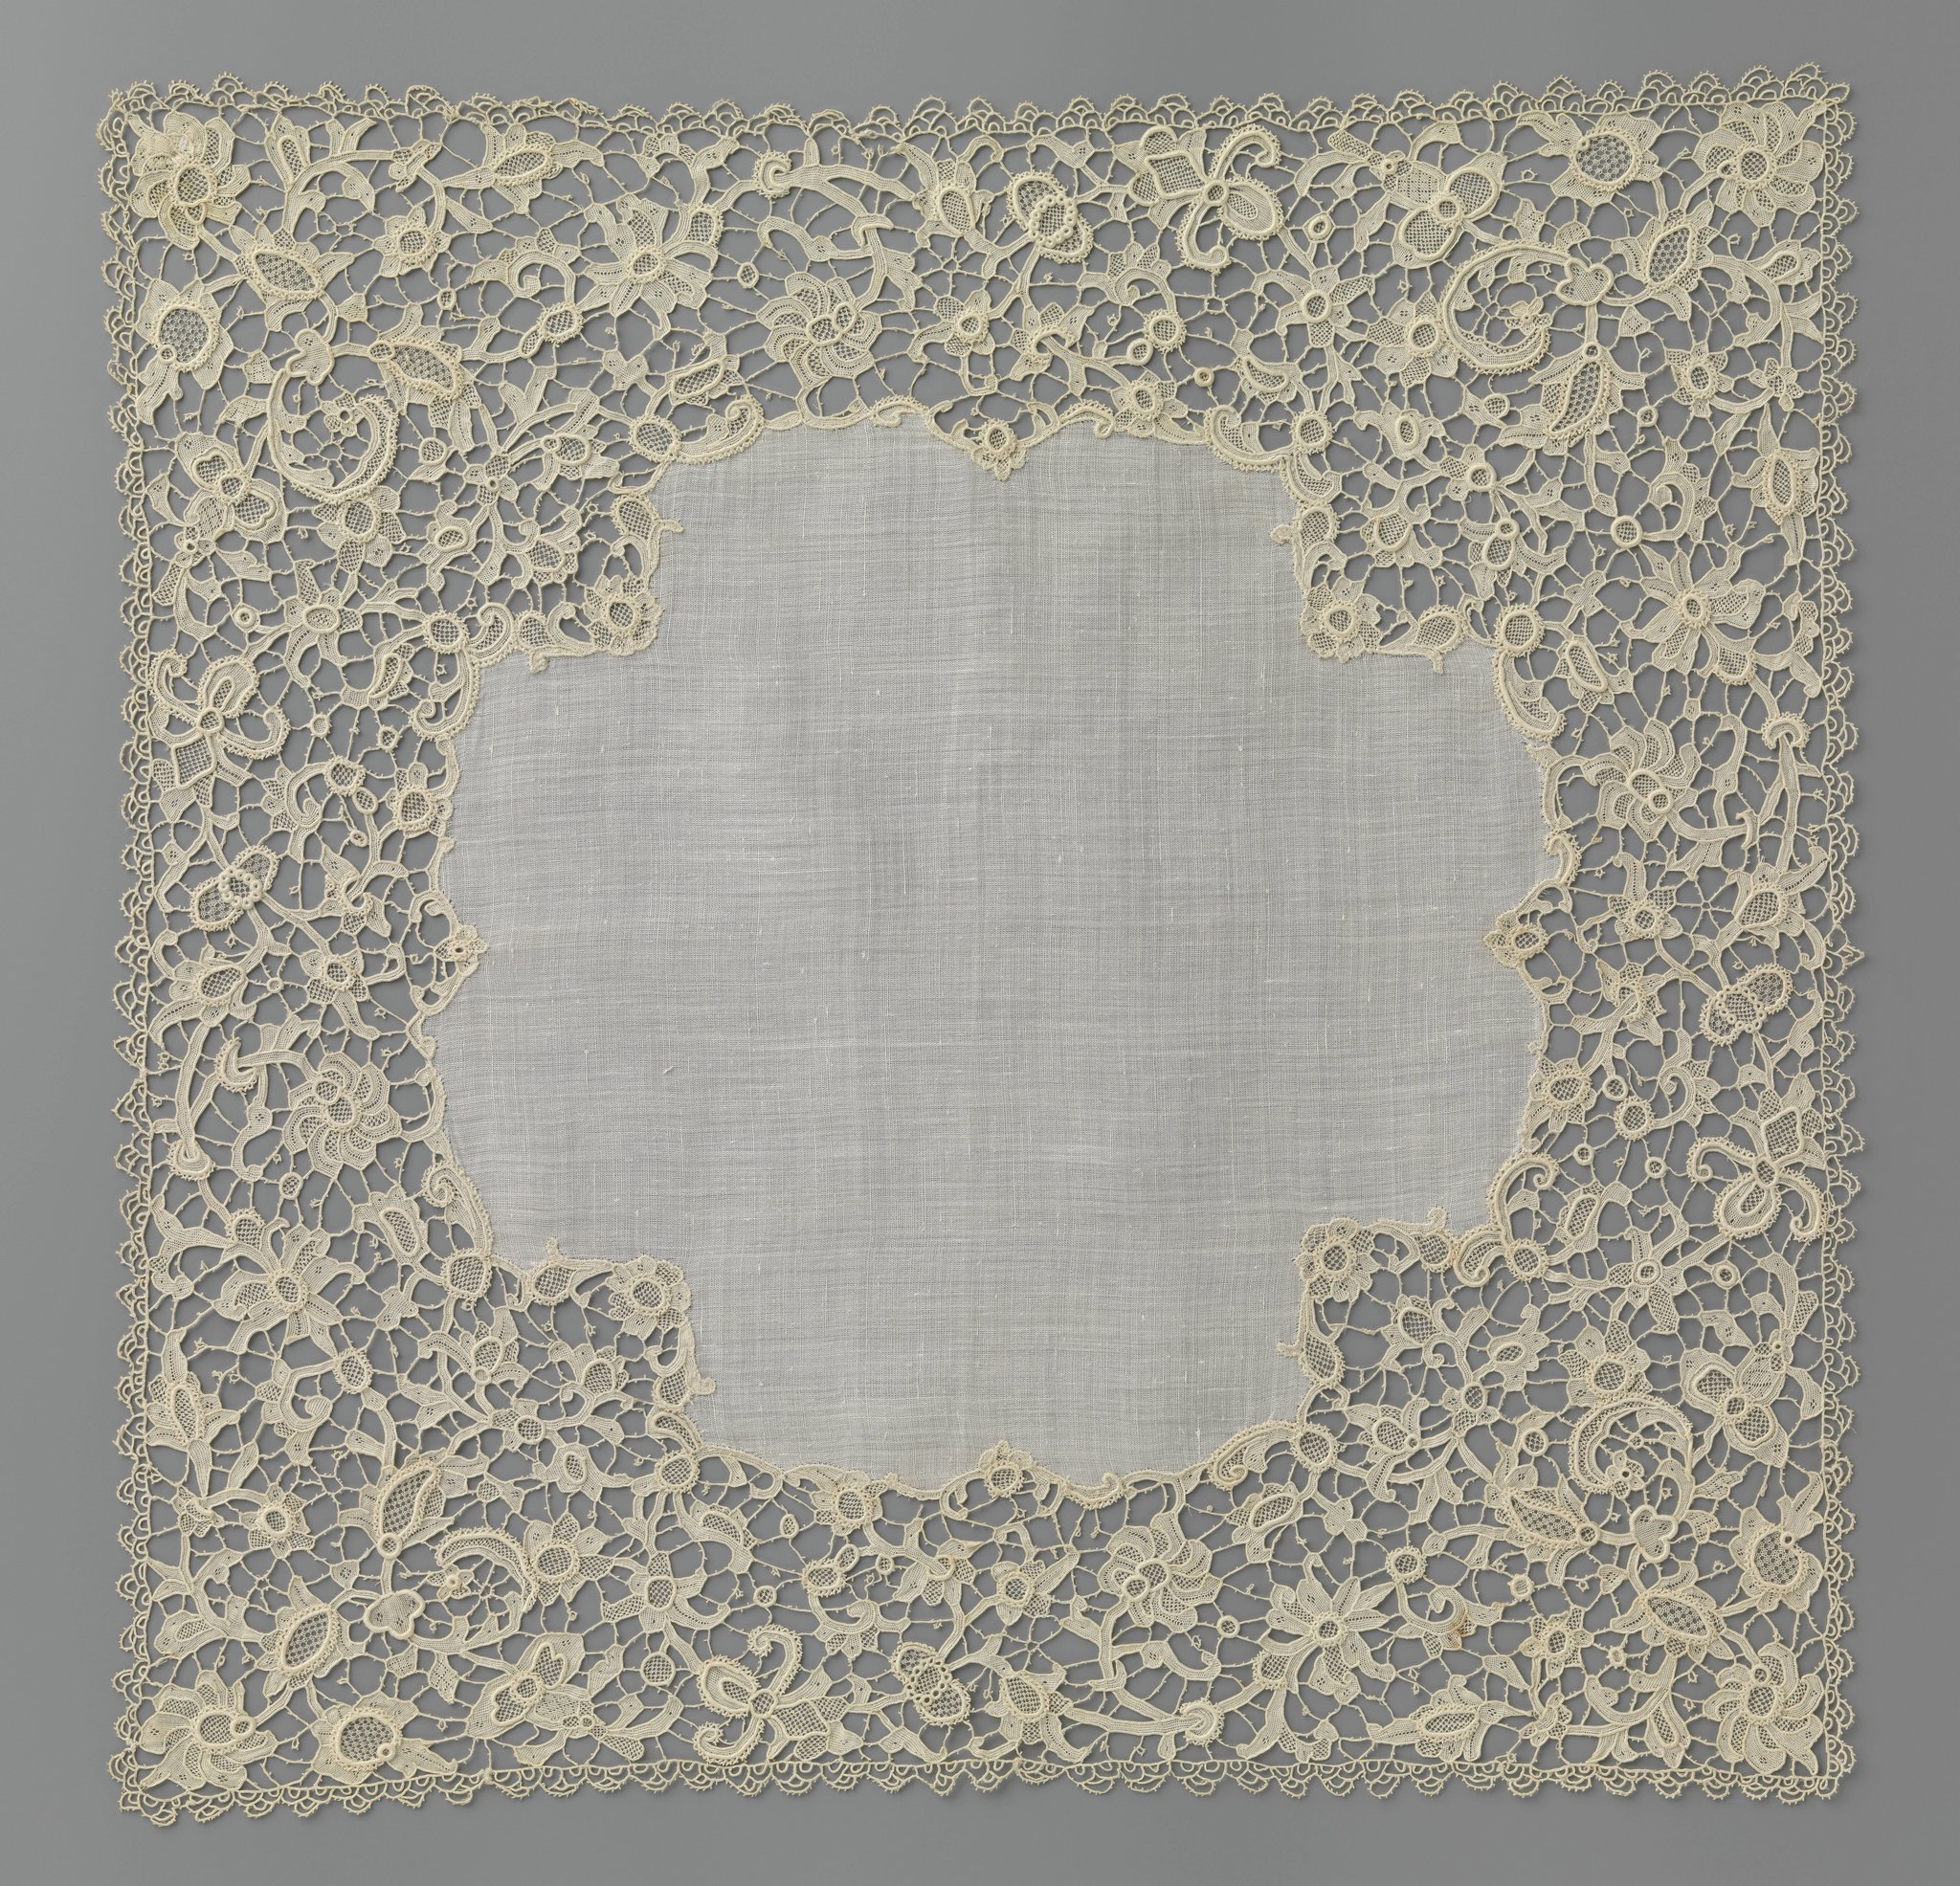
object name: handkerchief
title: Zakdoek van naaldkant met veermotief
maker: Anonymous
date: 1875-1910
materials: linen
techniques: embroidery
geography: burano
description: Zakdoek van naturelkleurige naaldkant: Venetiaanse reliëfkant. Geschulpt binnenstuk van linnen batist en een rand van naaldkant. Op de open spijlengrond staan ranken met veelsoortige bloemen, waaronder bloemen met een veermotief. Het patroon herhaalt zich in de vier hoeken.